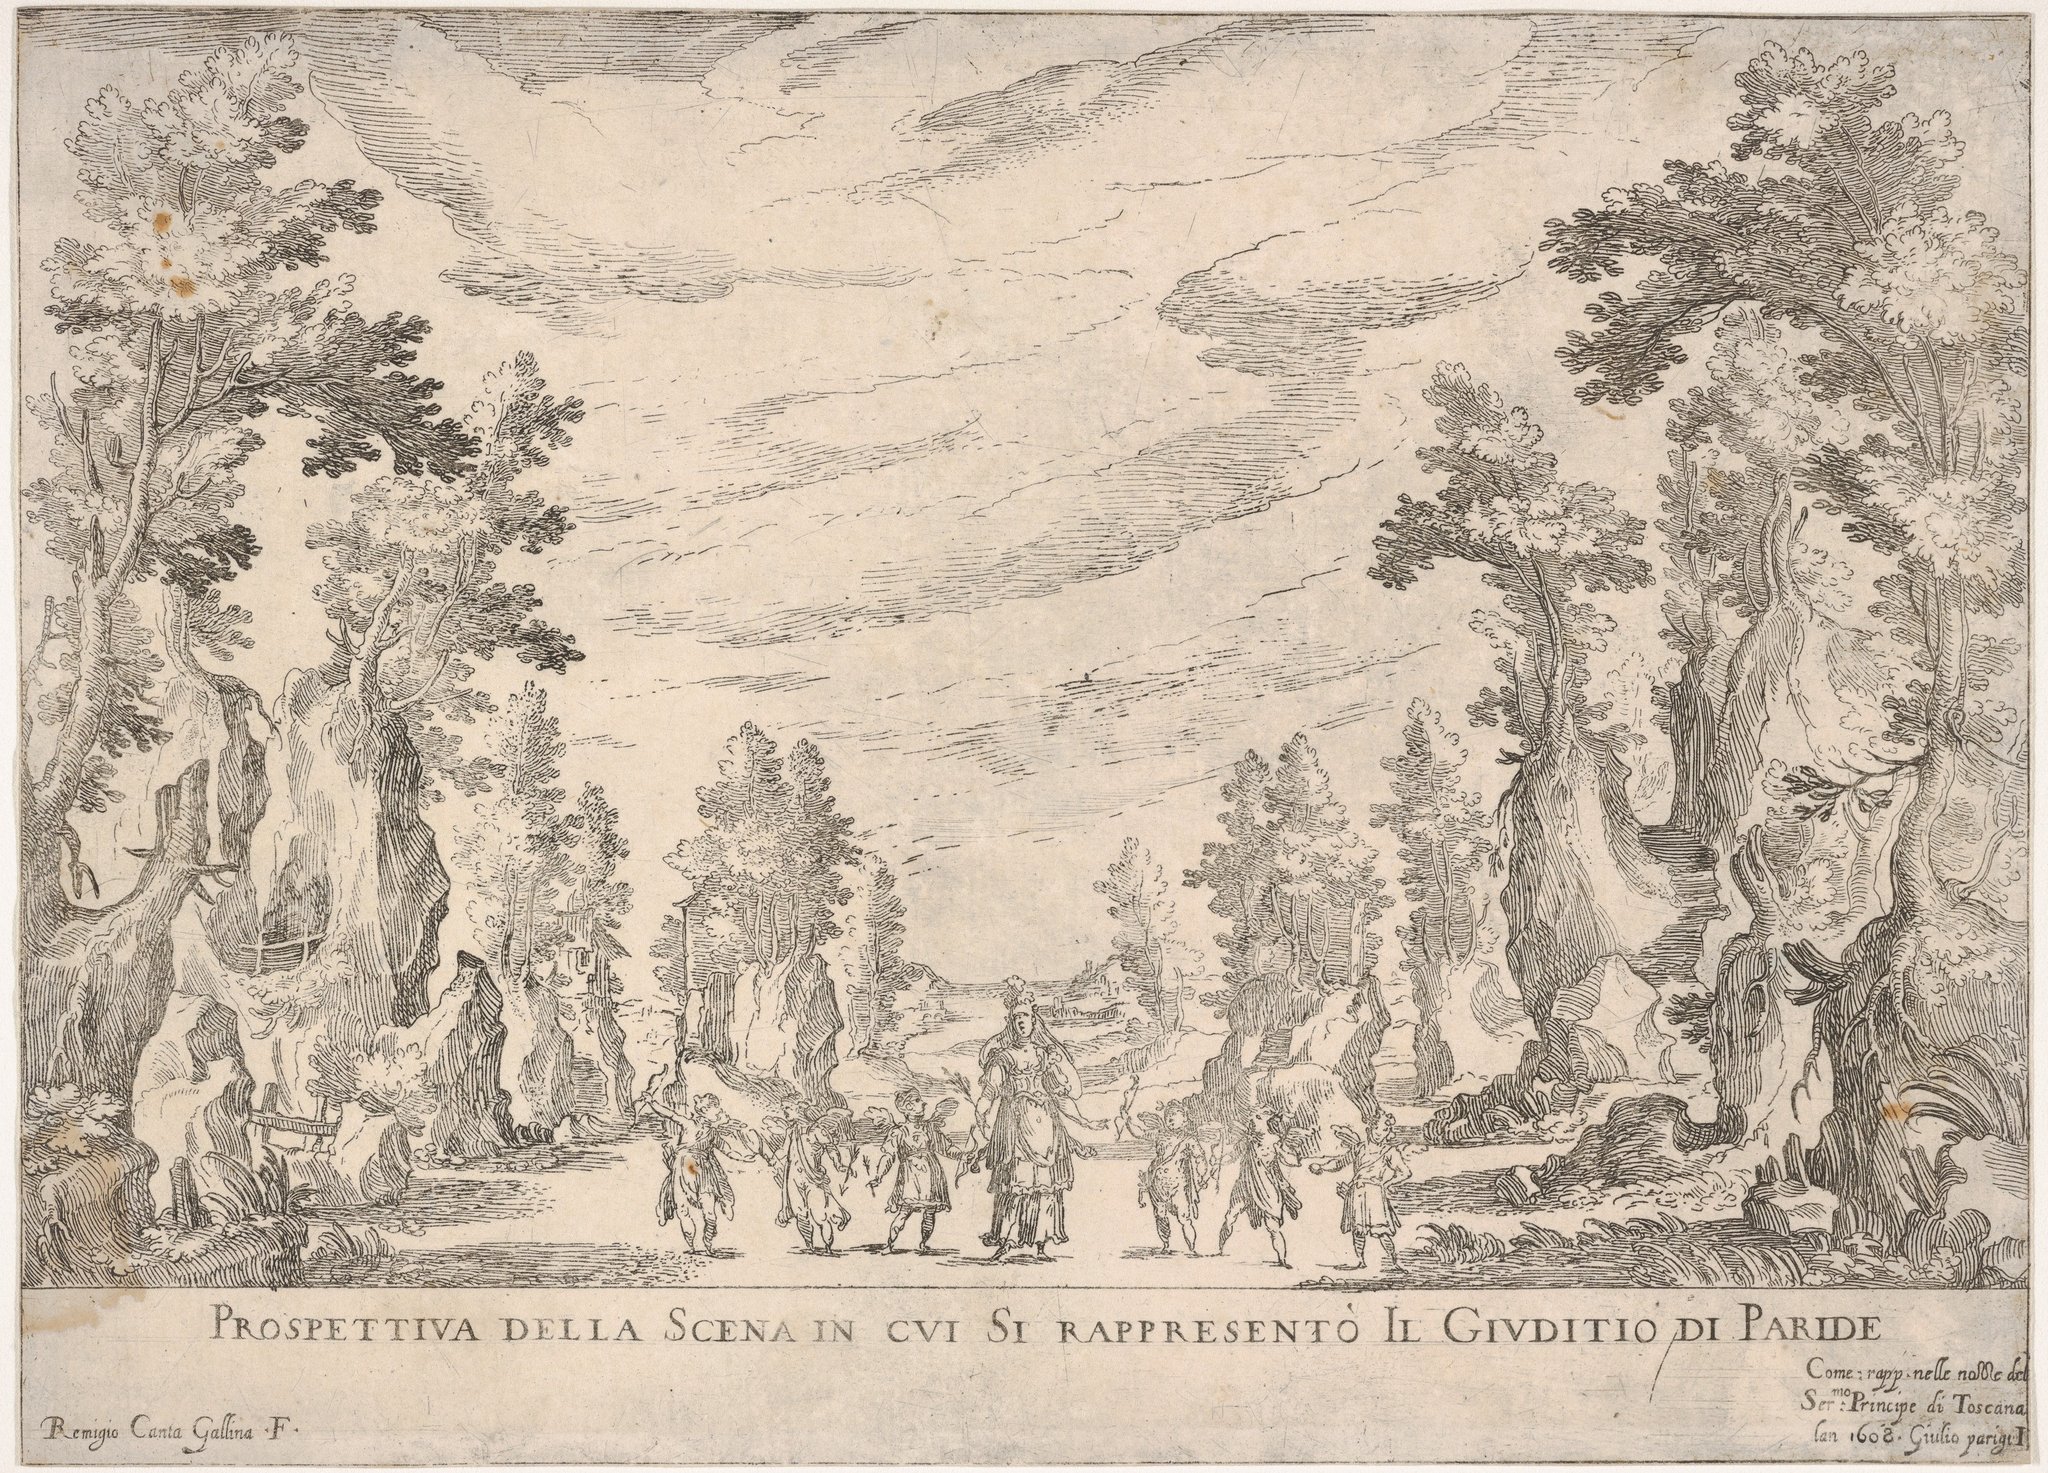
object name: print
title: View of the scene in which is represented the Judgment of Paris (Prospettiva della scena in cui si rappresentò il Giuditio do Paride), from "Seven Interludes for the wedding celebration of Cosimo de' Medici in Florence, 1608"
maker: remigio cantagallina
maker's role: artist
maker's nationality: italian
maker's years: 1582-1656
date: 1608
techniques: etching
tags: helen